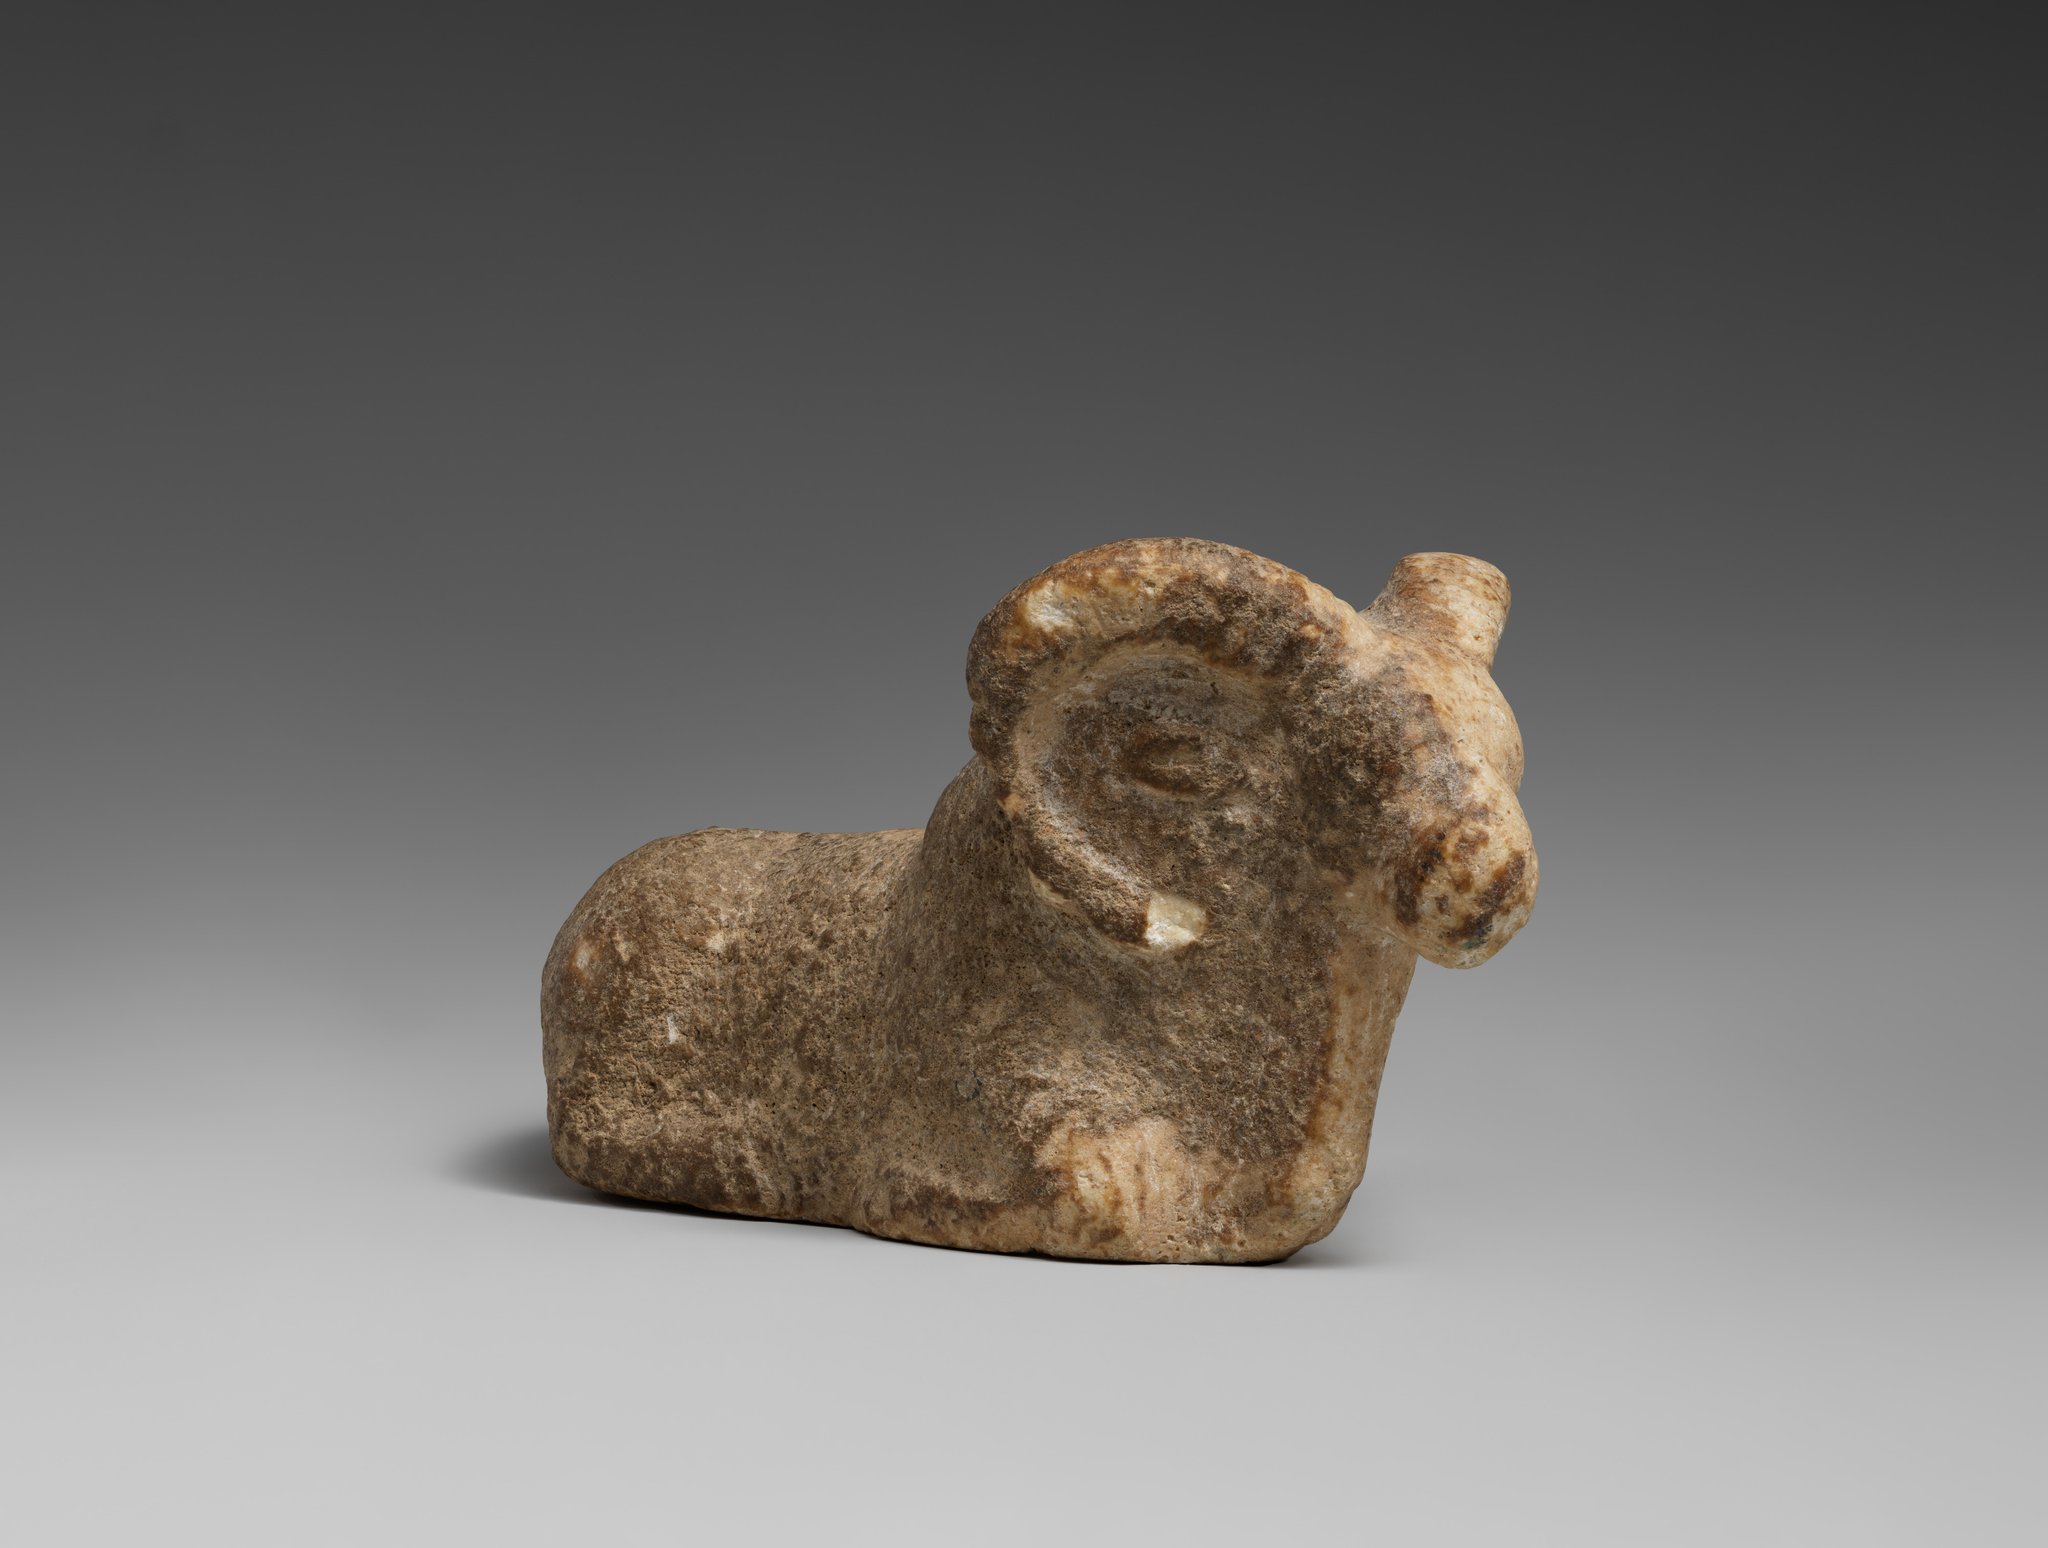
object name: sculpture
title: Reclining mouflon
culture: indus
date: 2600-1900 BCE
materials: marble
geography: indus valley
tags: sheep